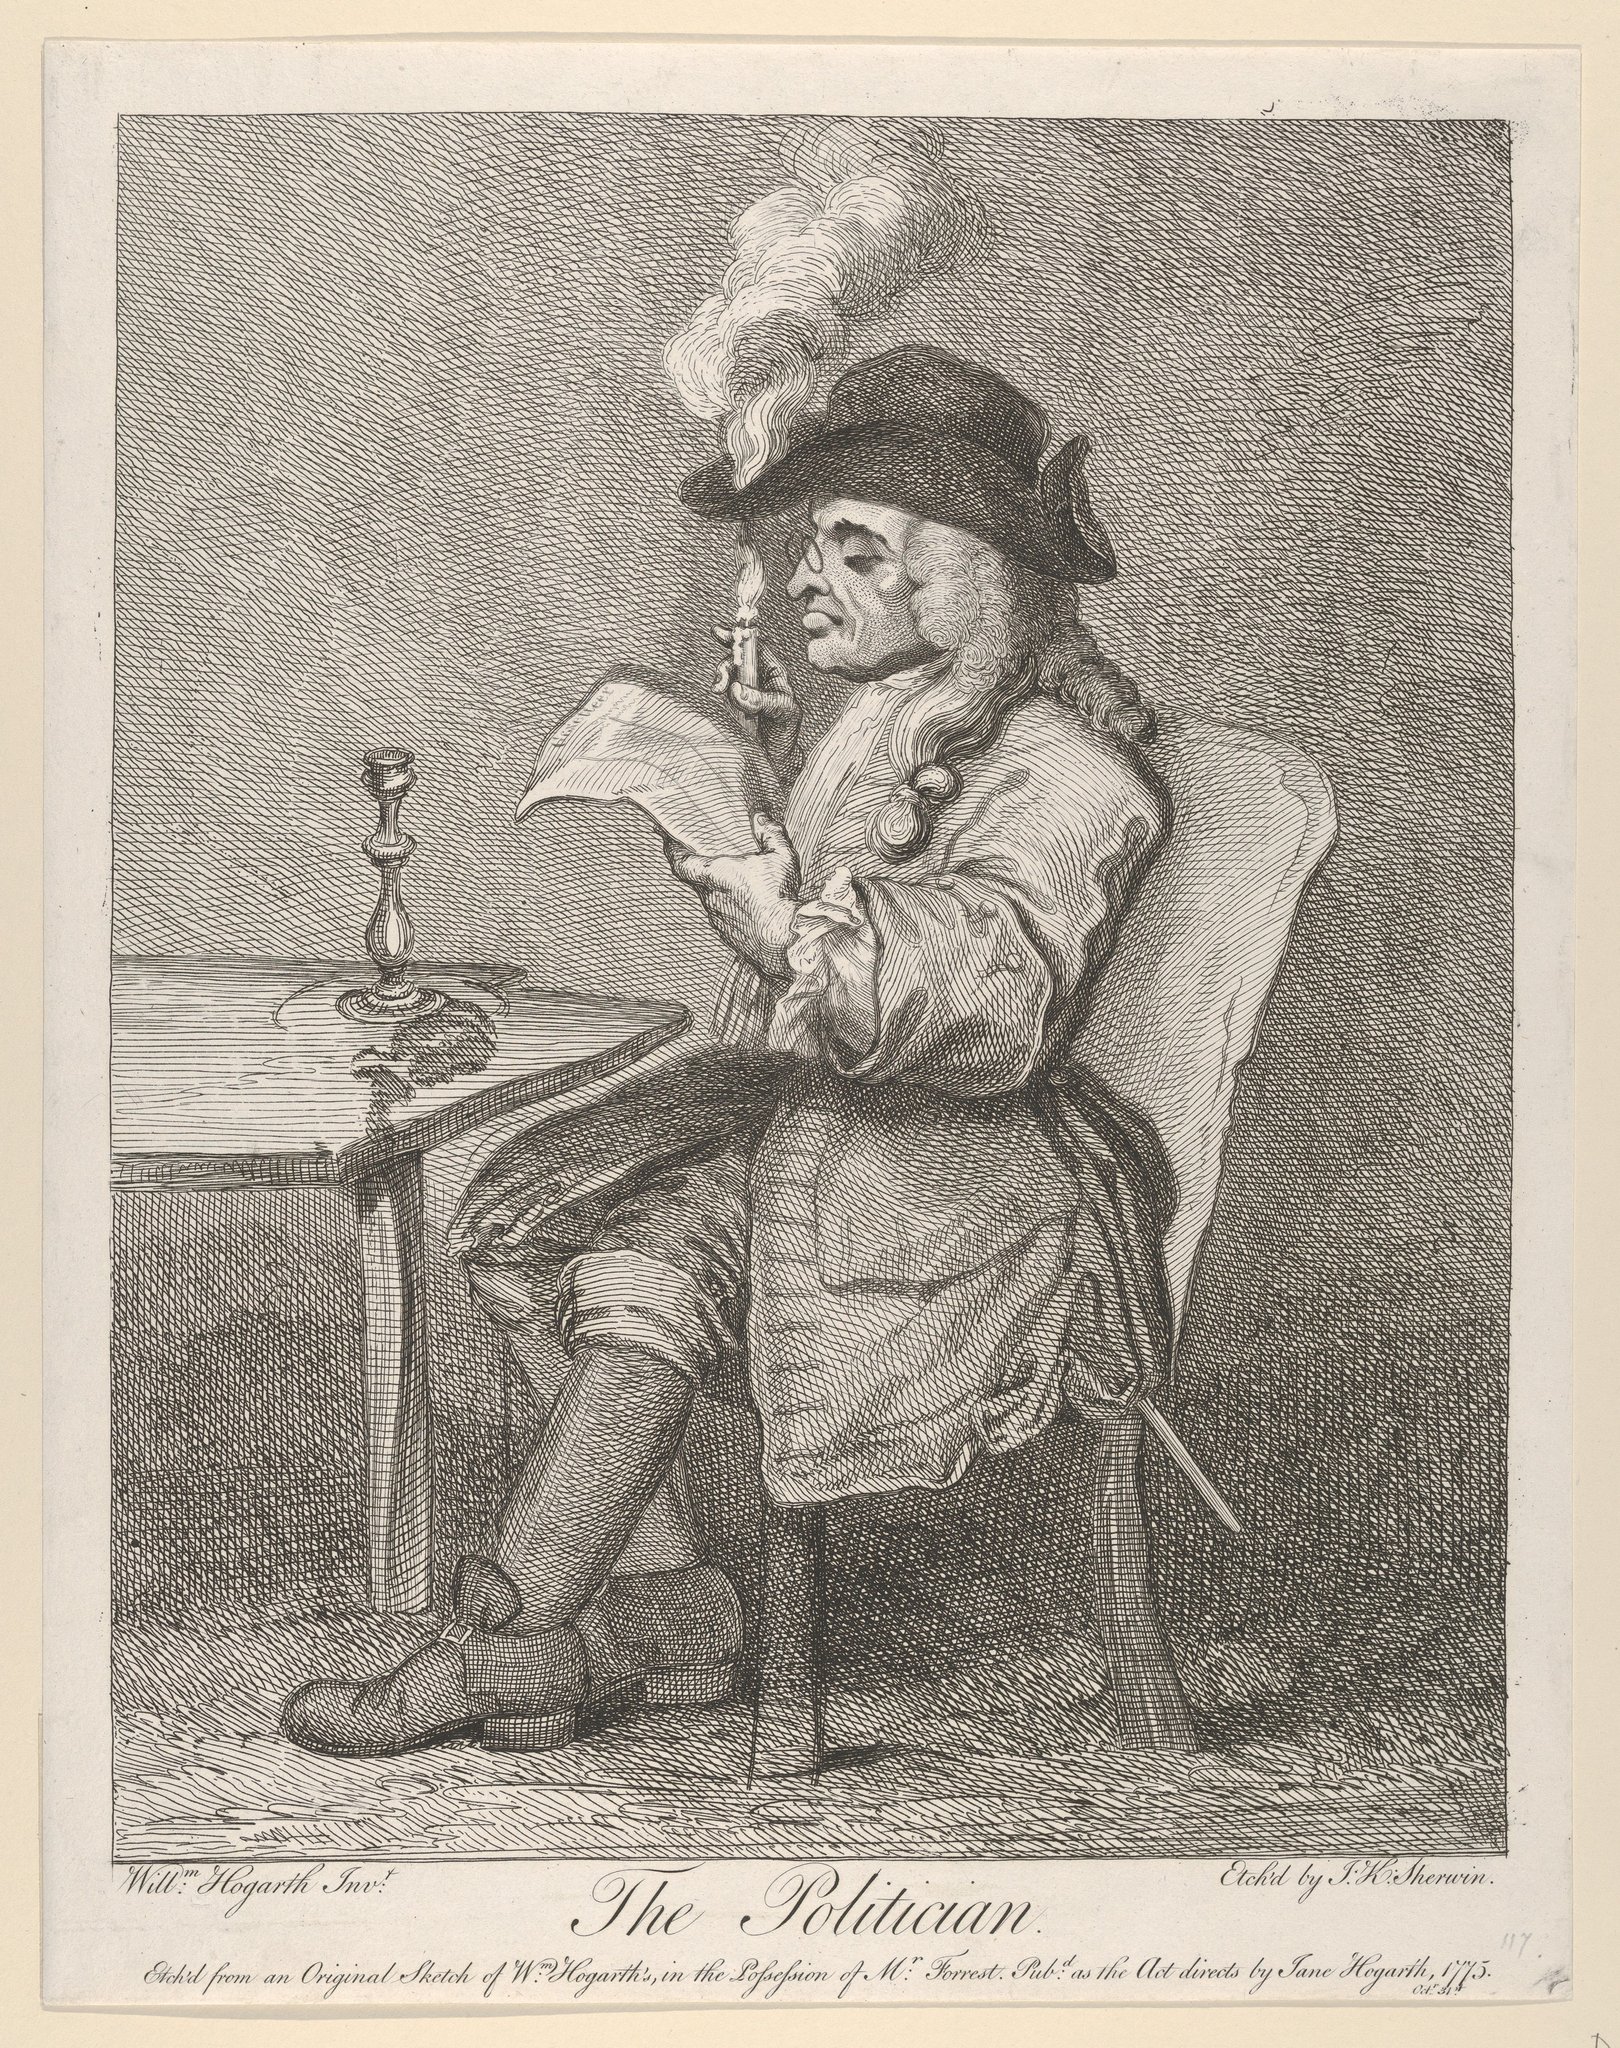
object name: print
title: The Politician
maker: john keyse sherwin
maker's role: etcher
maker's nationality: british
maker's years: 1751-1790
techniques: etching, engraving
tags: satire,men,reading,fire,candles